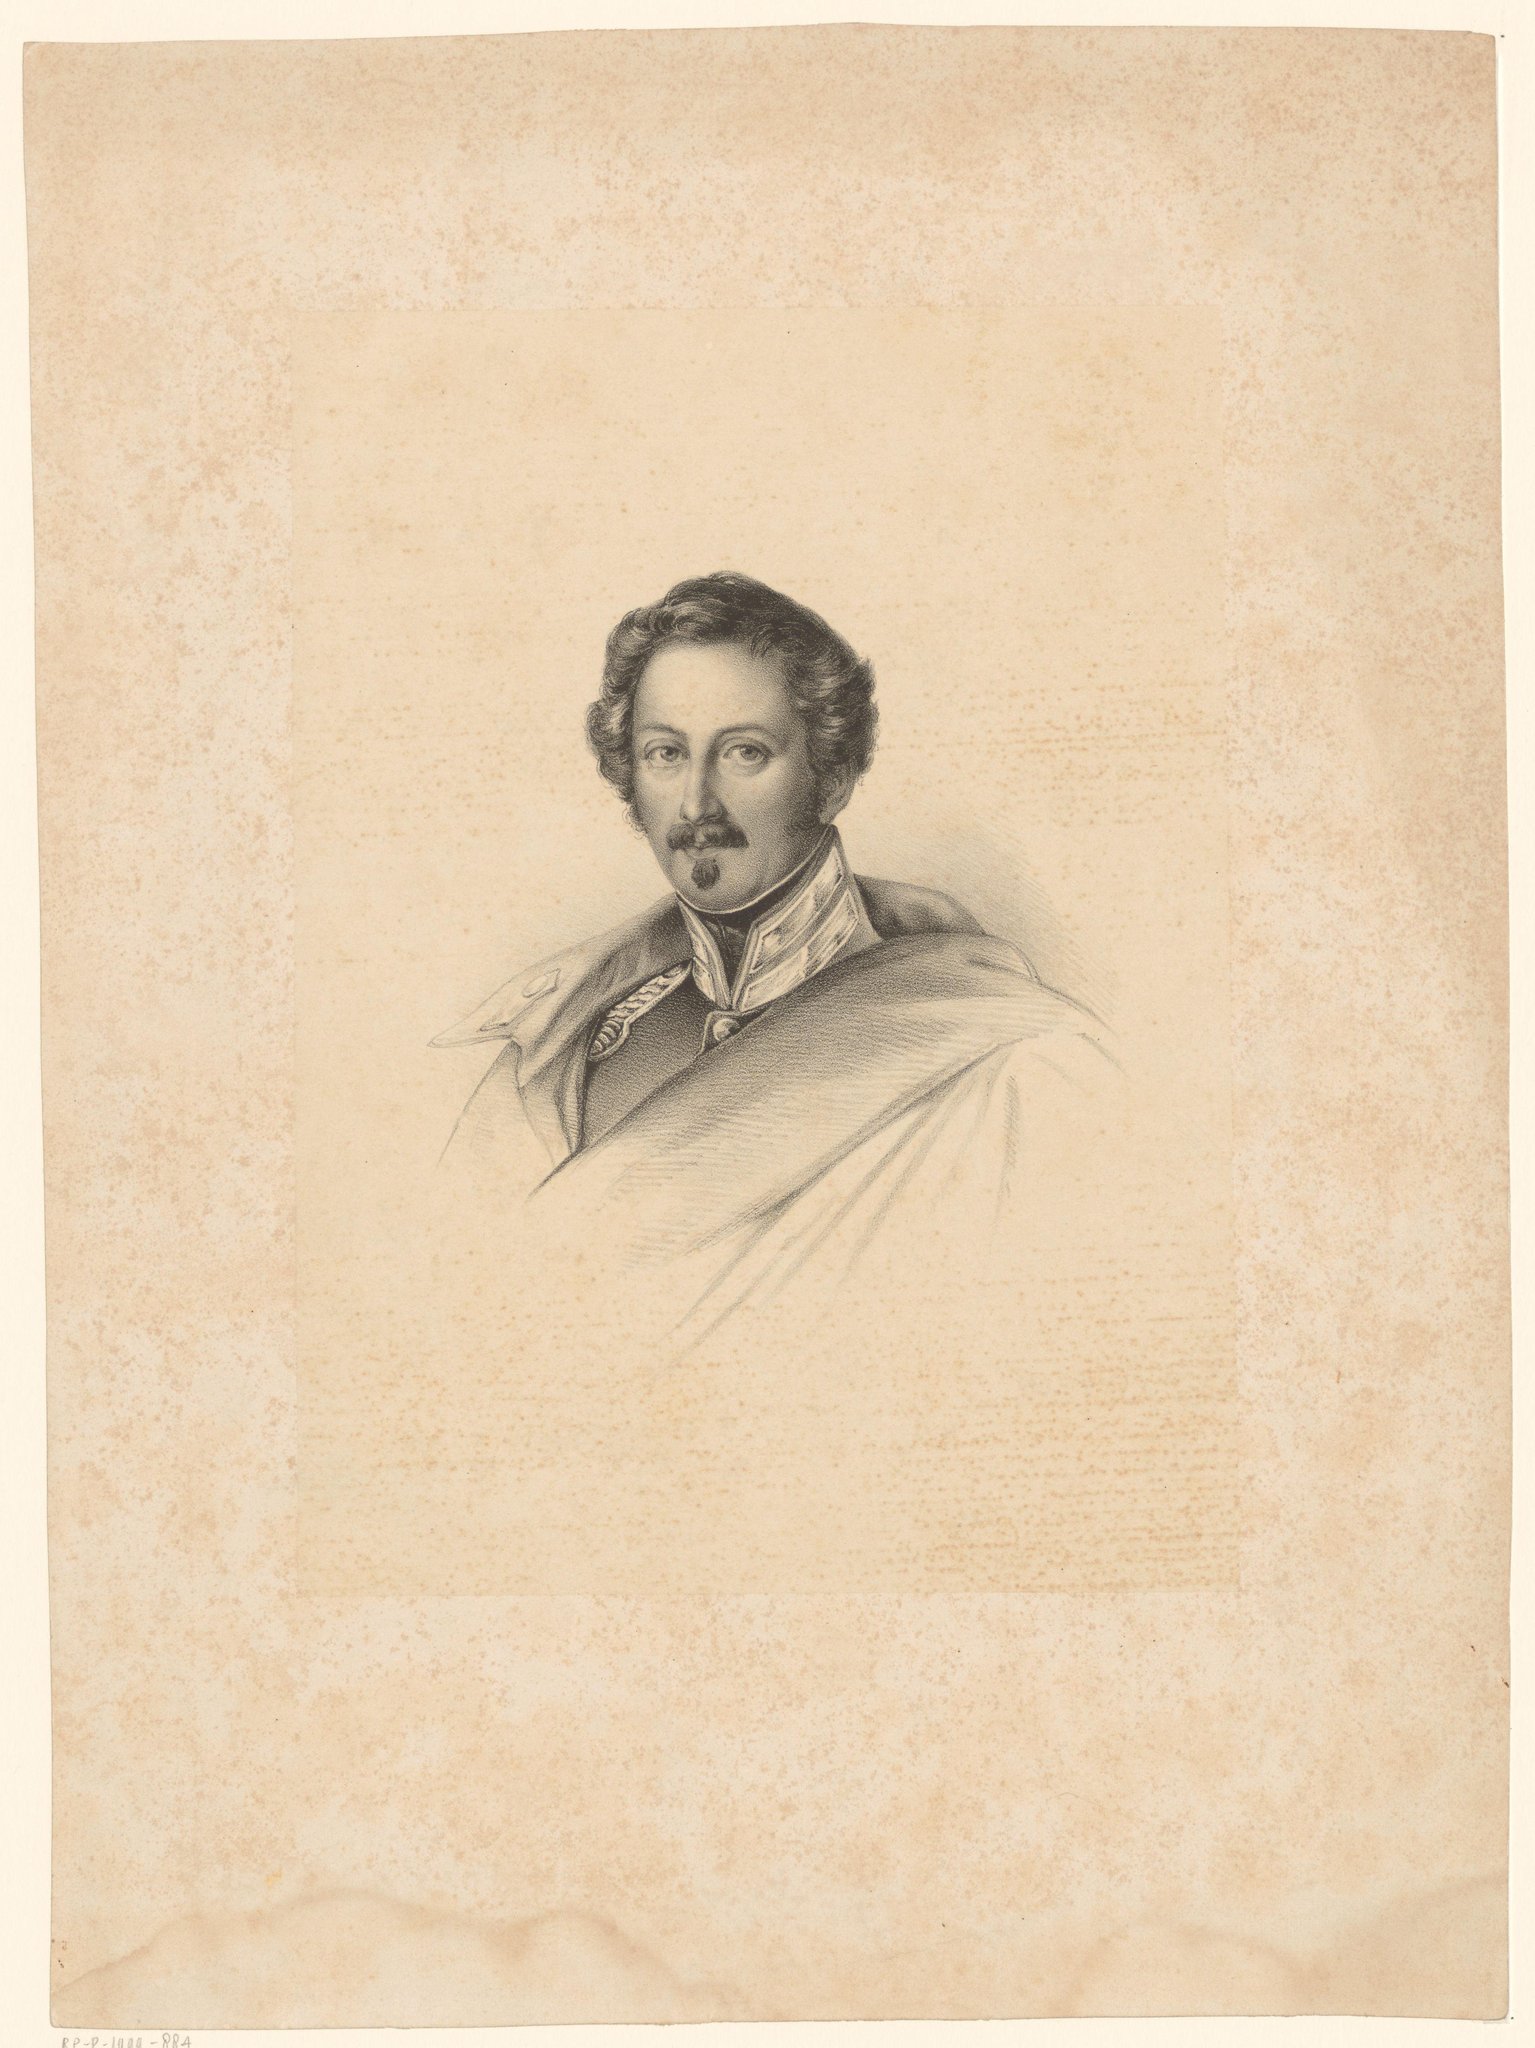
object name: print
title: Portret van een onbekende man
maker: Anonymous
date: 1820-1899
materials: paper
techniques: lithograph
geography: germany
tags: adult man, historical persons, beard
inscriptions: mark: Lugt 4100, collector's mark: Lugt 2228, collector's mark: Lugt 2760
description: Buste naar links, in uniform, met mantel.